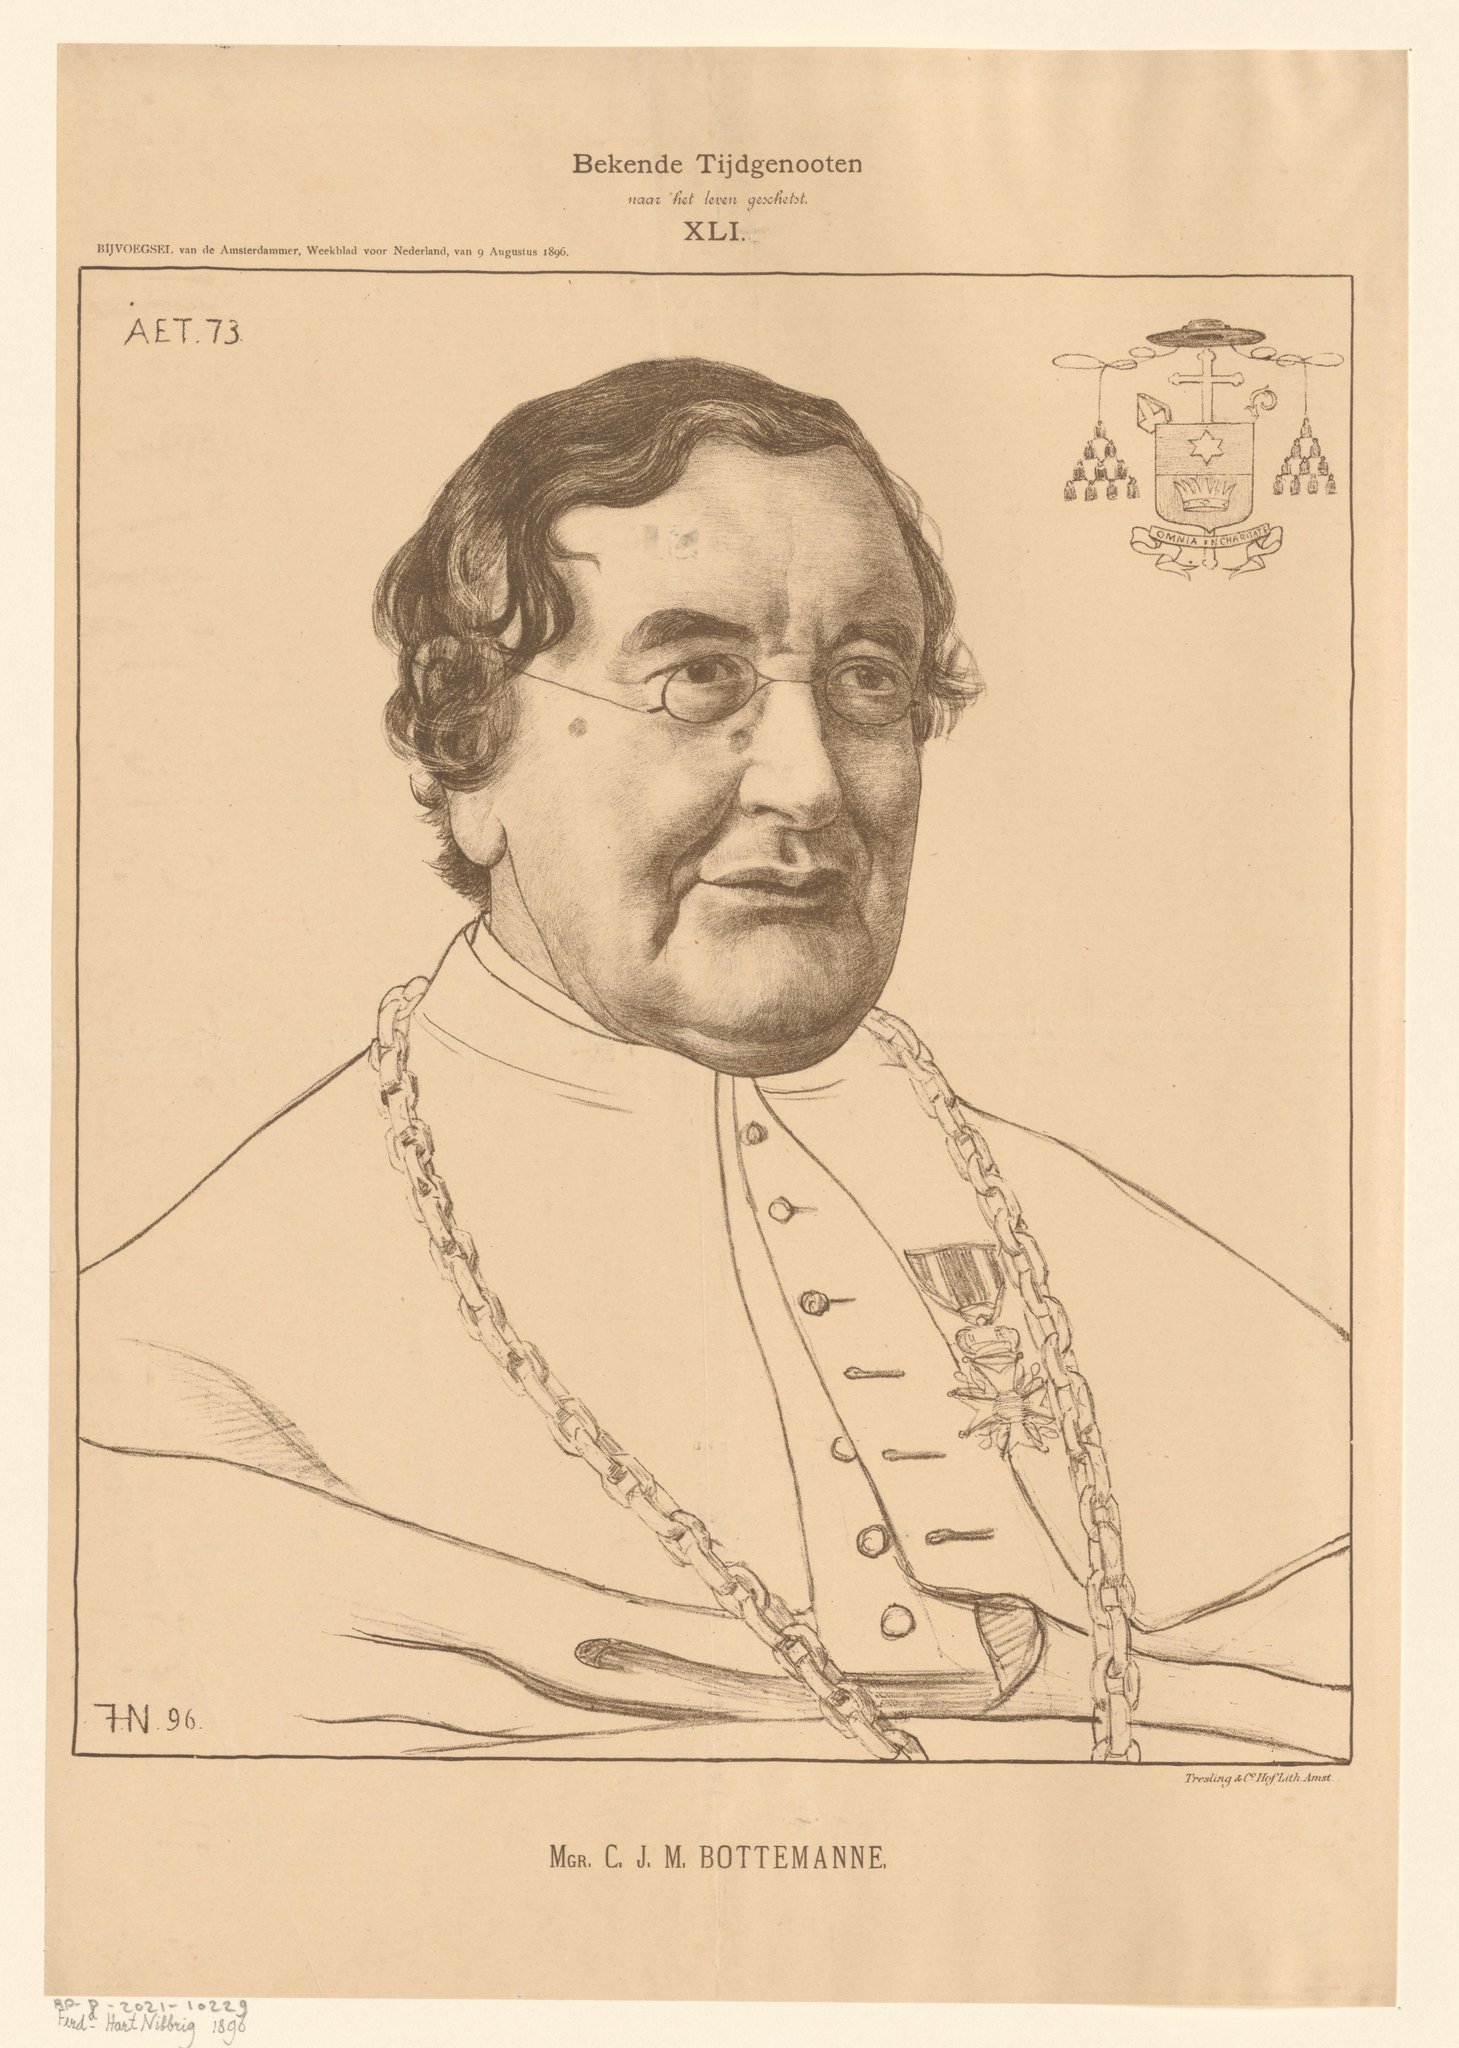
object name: print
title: Bekende tijdgenooten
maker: ferdinand hart nibbrig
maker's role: draughtsman, painter, print maker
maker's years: 1866-1915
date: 1896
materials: paper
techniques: lithograph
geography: amsterdam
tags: haarlem, archbishop, bishop, etc. (roman catholic), historical persons, armorial bearing, heraldry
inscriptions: collector's mark: Lugt 2228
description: Verschenen in het bijvoegsel van: De Amsterdammer, Weekblad voor Nederland, 9 augustus 1896.